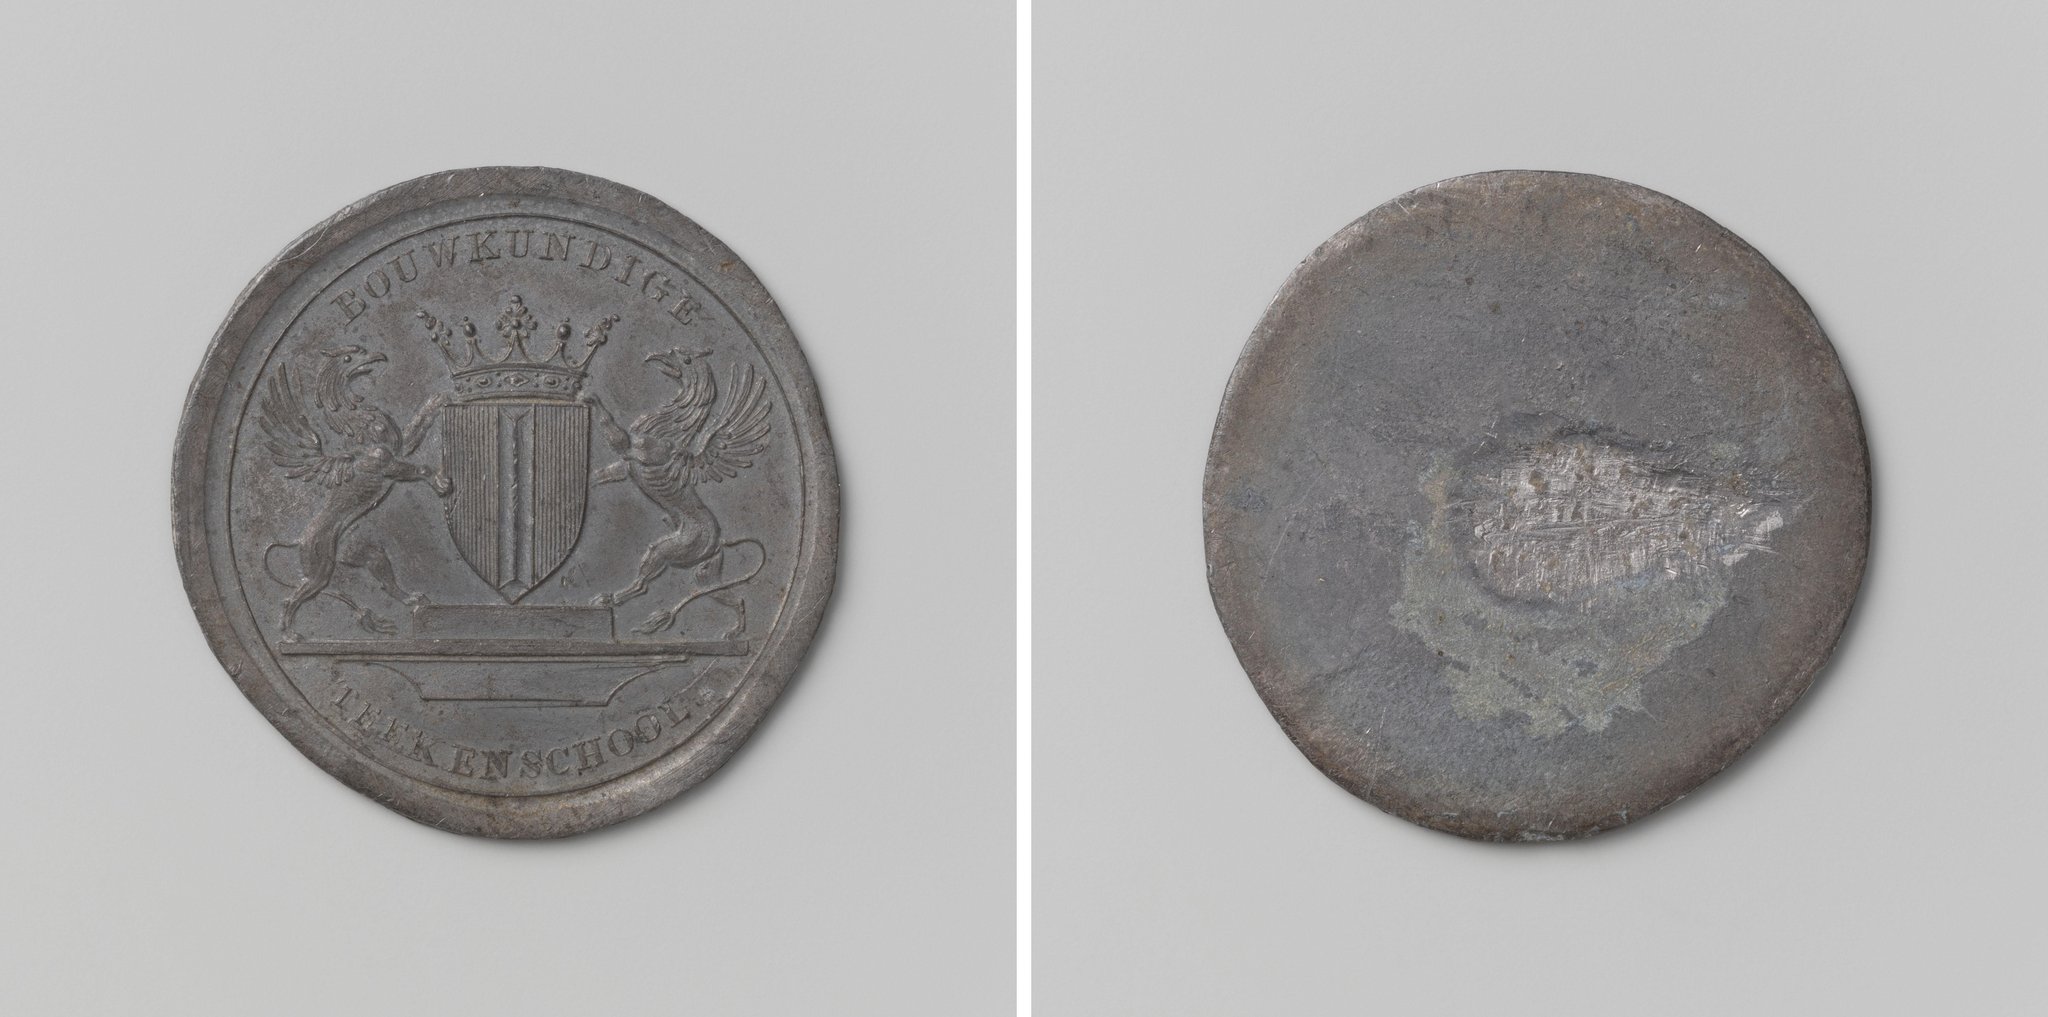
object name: medal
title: Bouwkundige teekenschool te Delft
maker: Anonymous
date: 1825-1875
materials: lead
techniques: striking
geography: netherlands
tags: delft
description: Eenzijdige loden penning. Voorzijde: gekroond wapenschild, geflankeerd door twee griffioenen binnen omschrift. Keerzijde: blanco